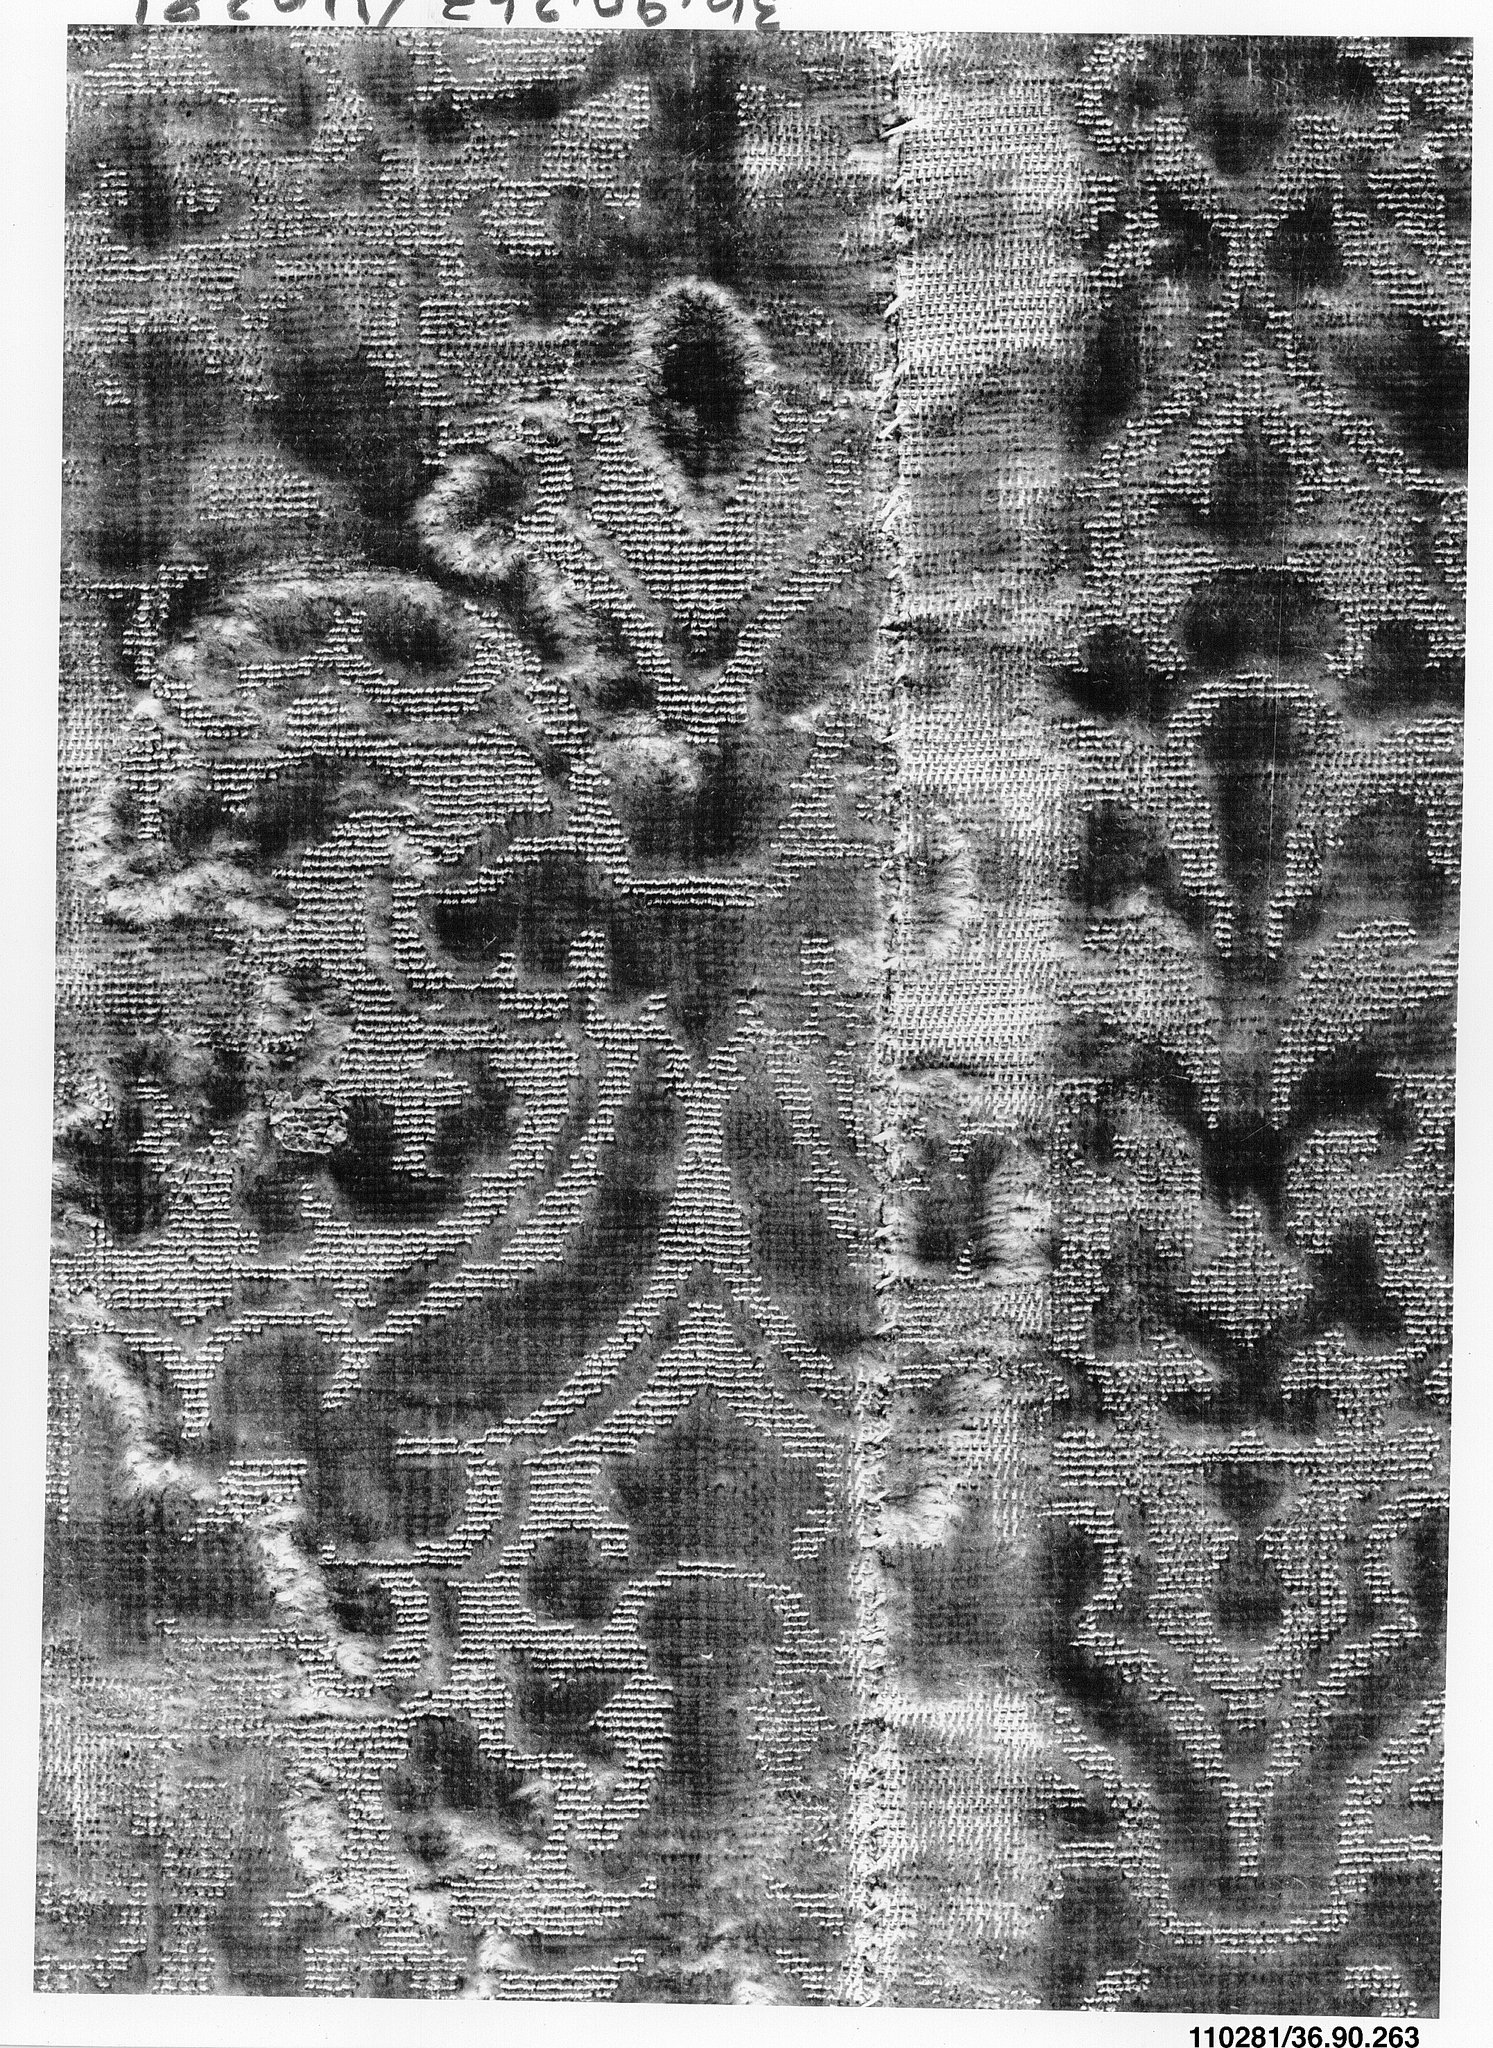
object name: piece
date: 1501-1700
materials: silk